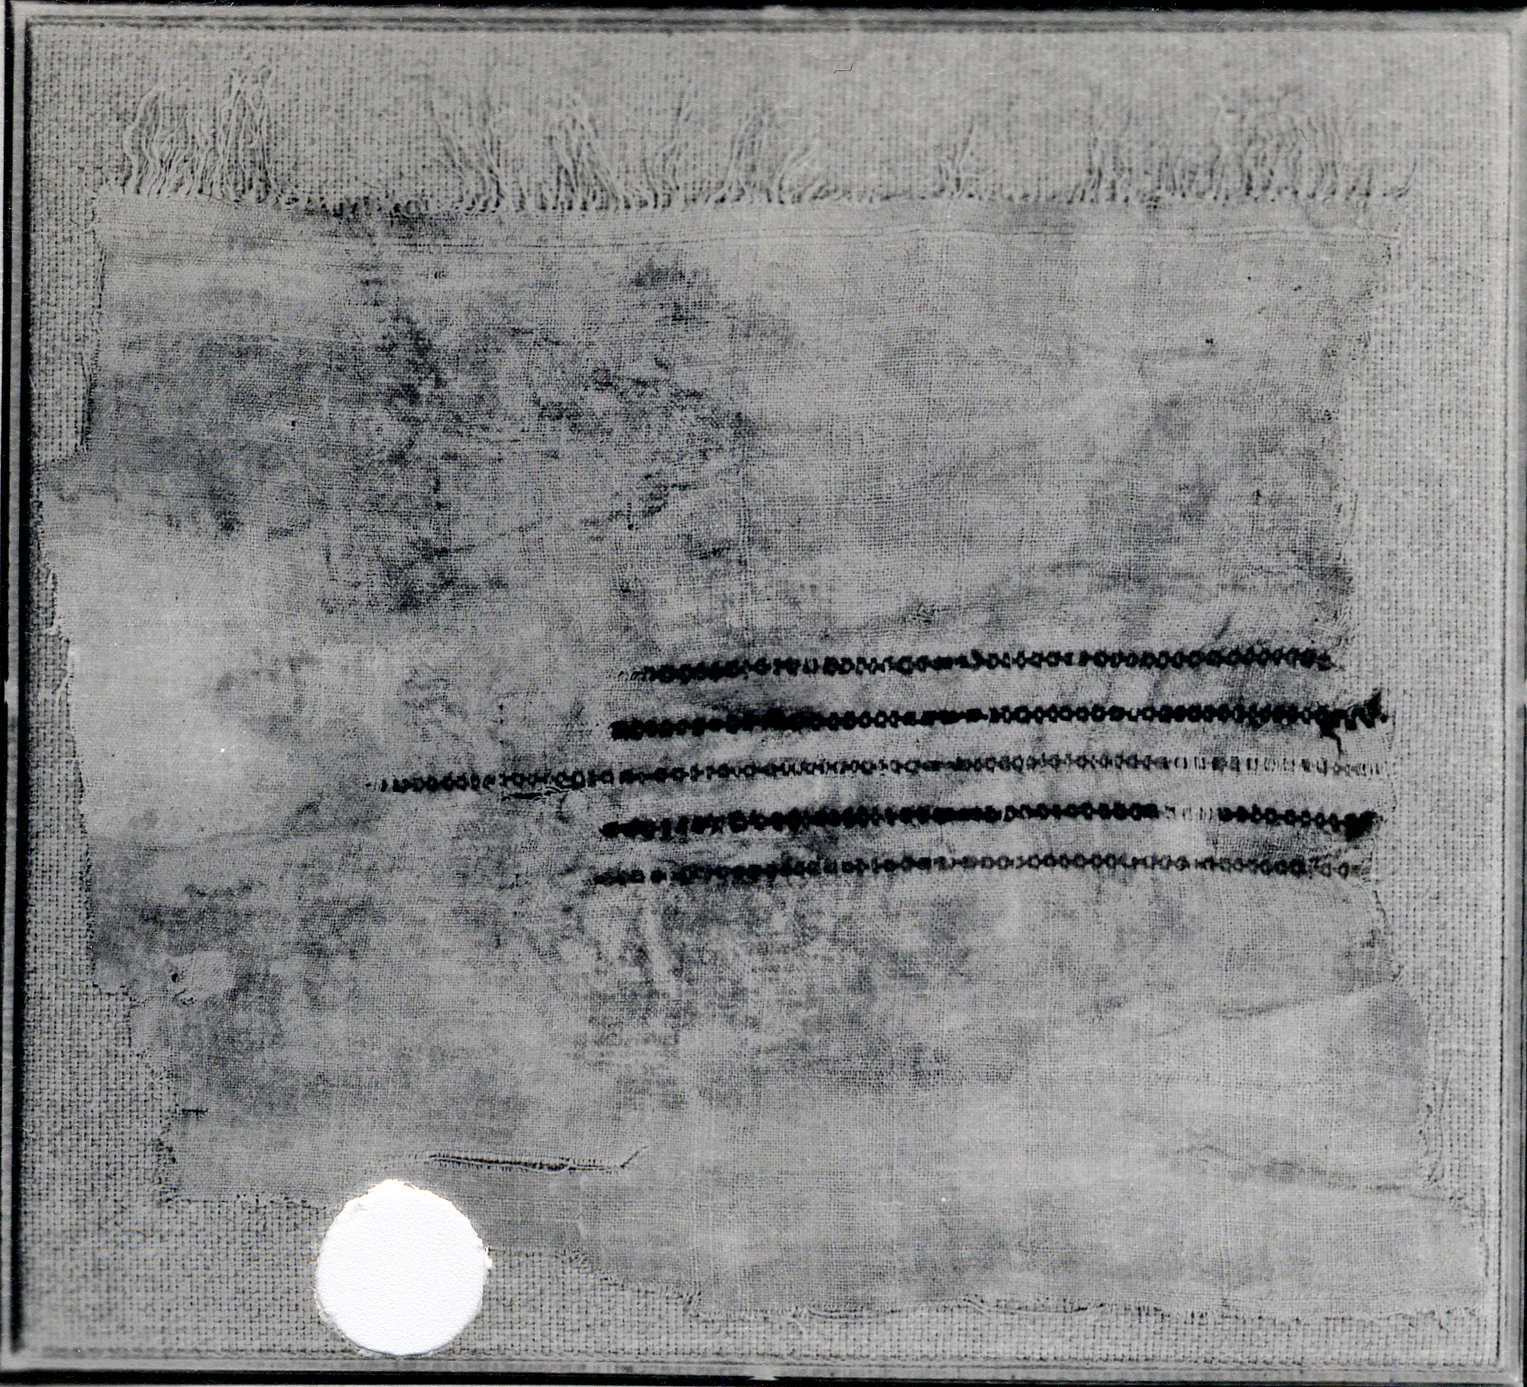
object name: fragment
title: Dress Fragment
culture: coptic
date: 301-400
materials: linen, wool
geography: egypt